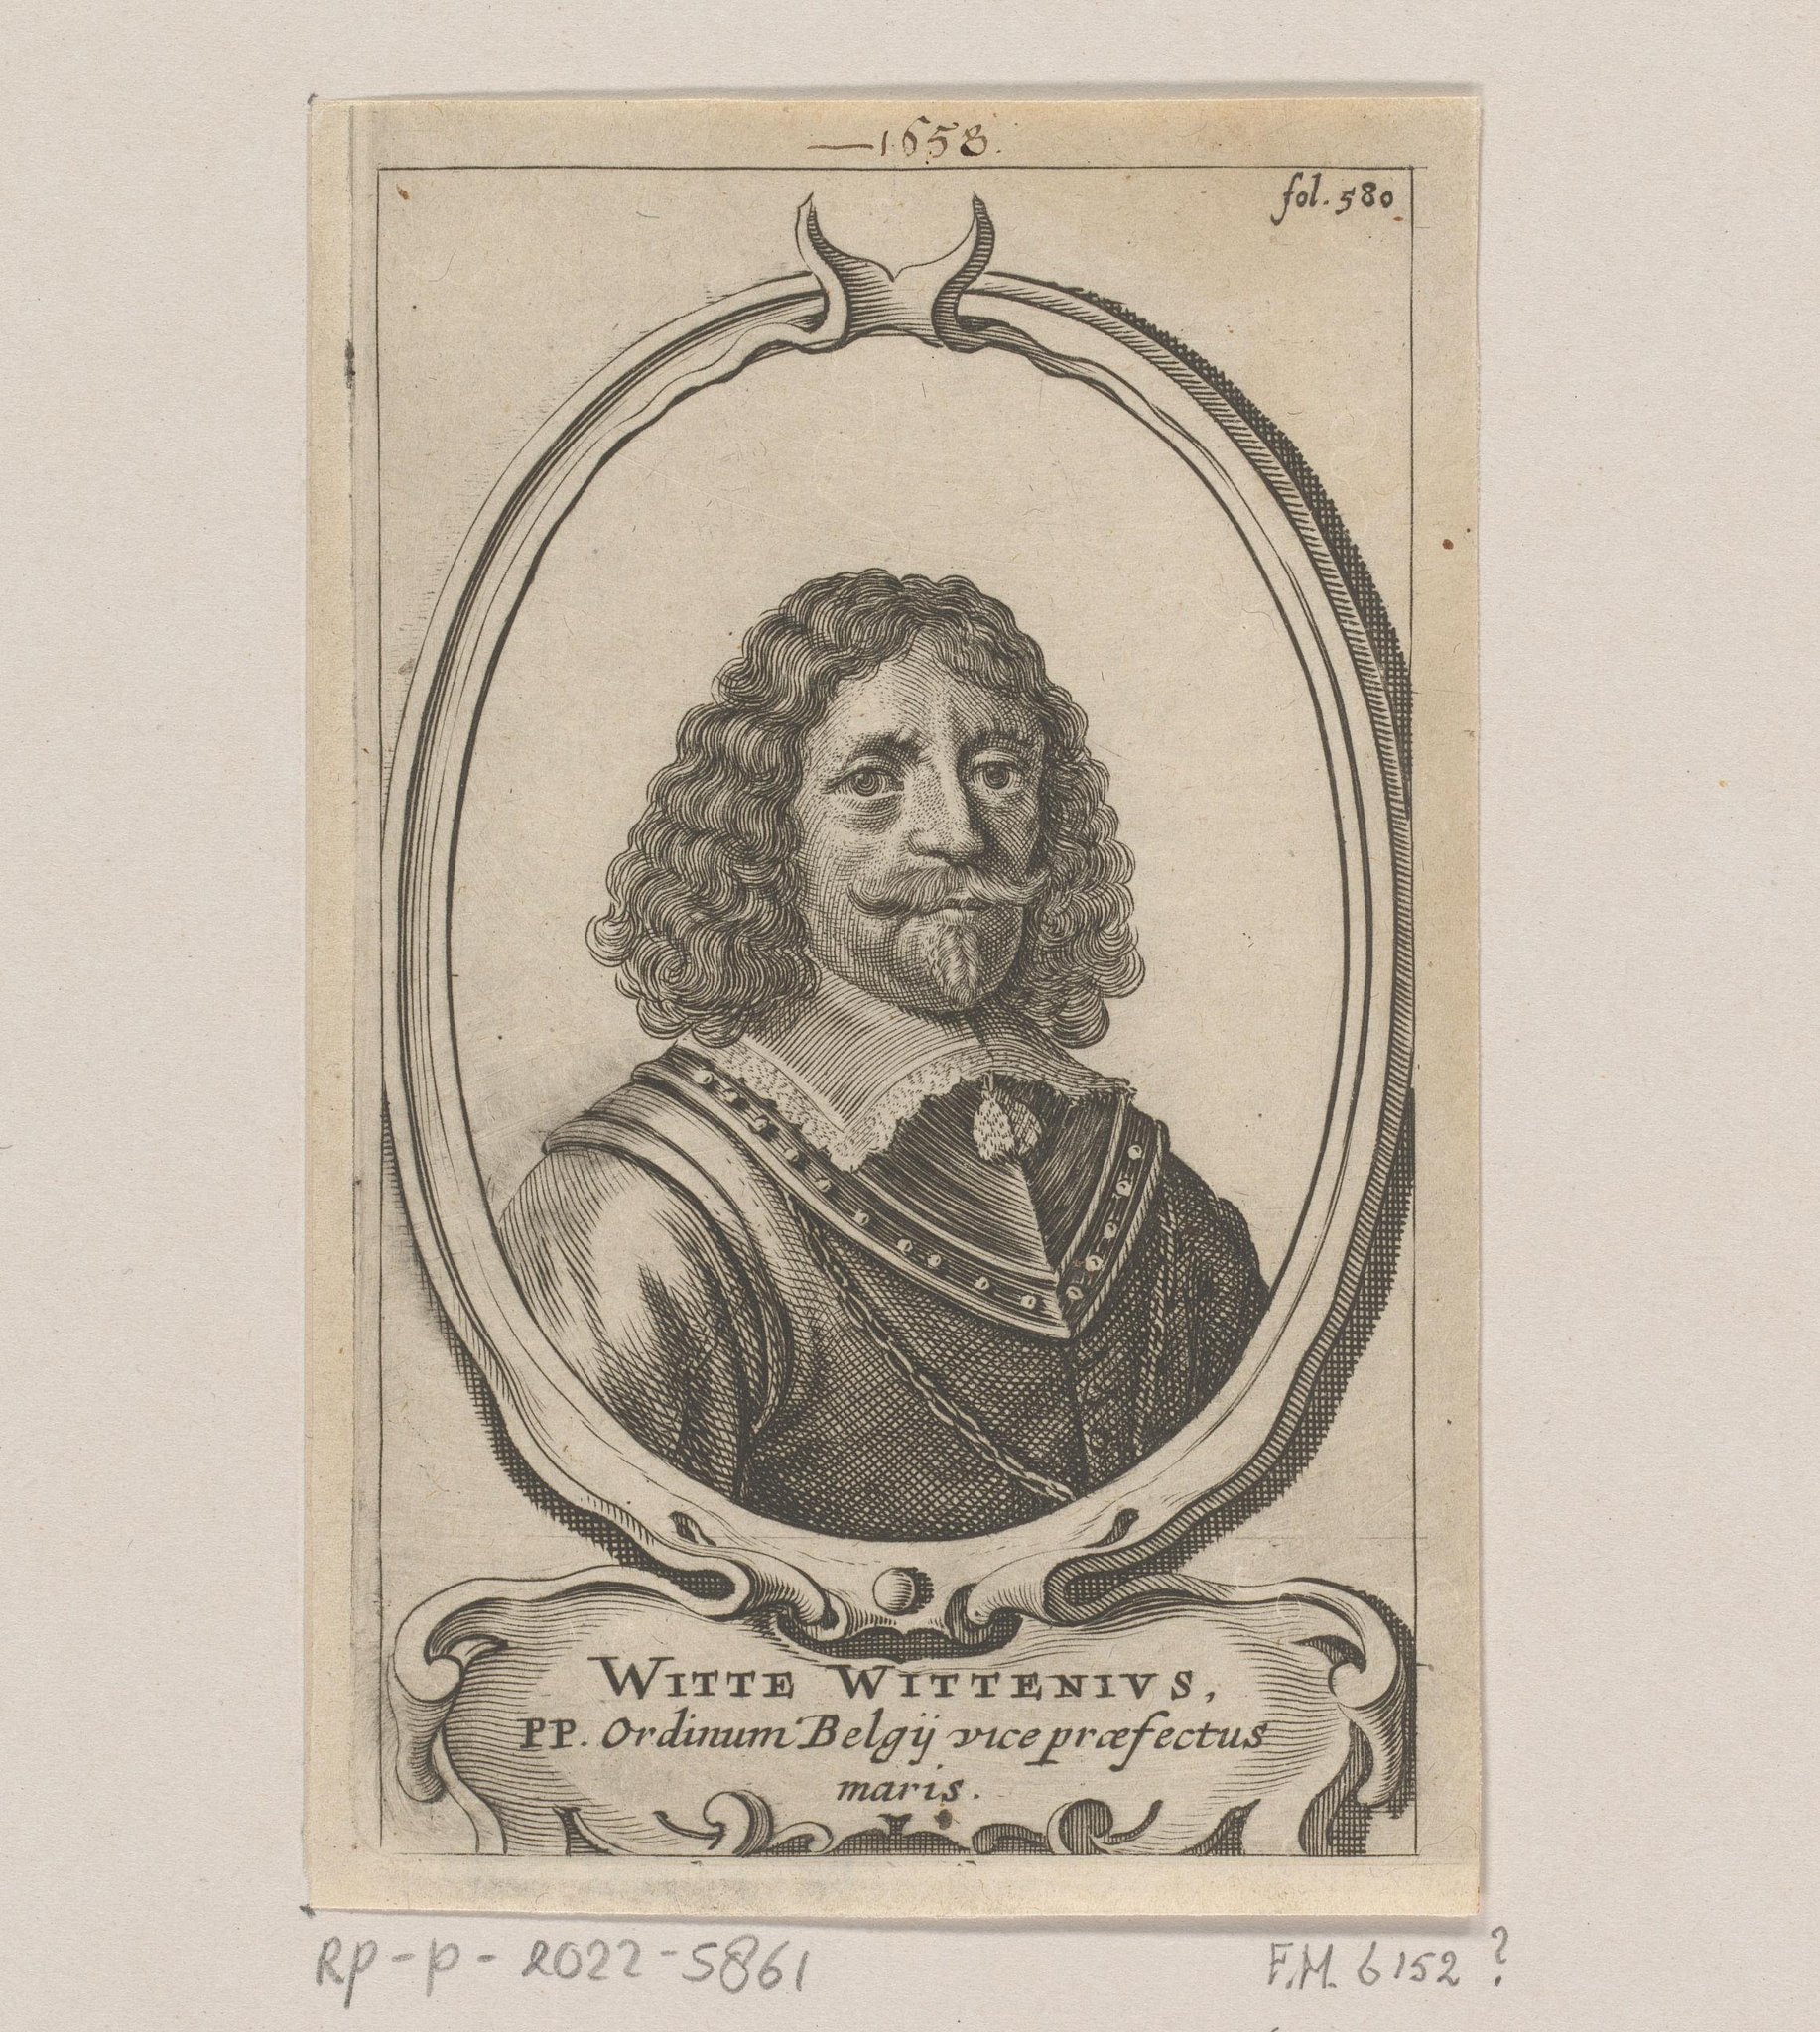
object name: book illustration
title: Portret van Witte Cornelisz. de With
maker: Anonymous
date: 1656-1666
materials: paper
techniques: engraving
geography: amsterdam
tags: historical persons, commander-in-chief, admiral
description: Prent waarschijnlijk uit: Brachelius, Johannes Adolphus. Historia nostri temporis, dat is geschiedenis onses tijts (…). Rotterdam: Andries van Hoogenhuysen, 1656. Prent ook gebruikt in de 1659- en 1666-editie.